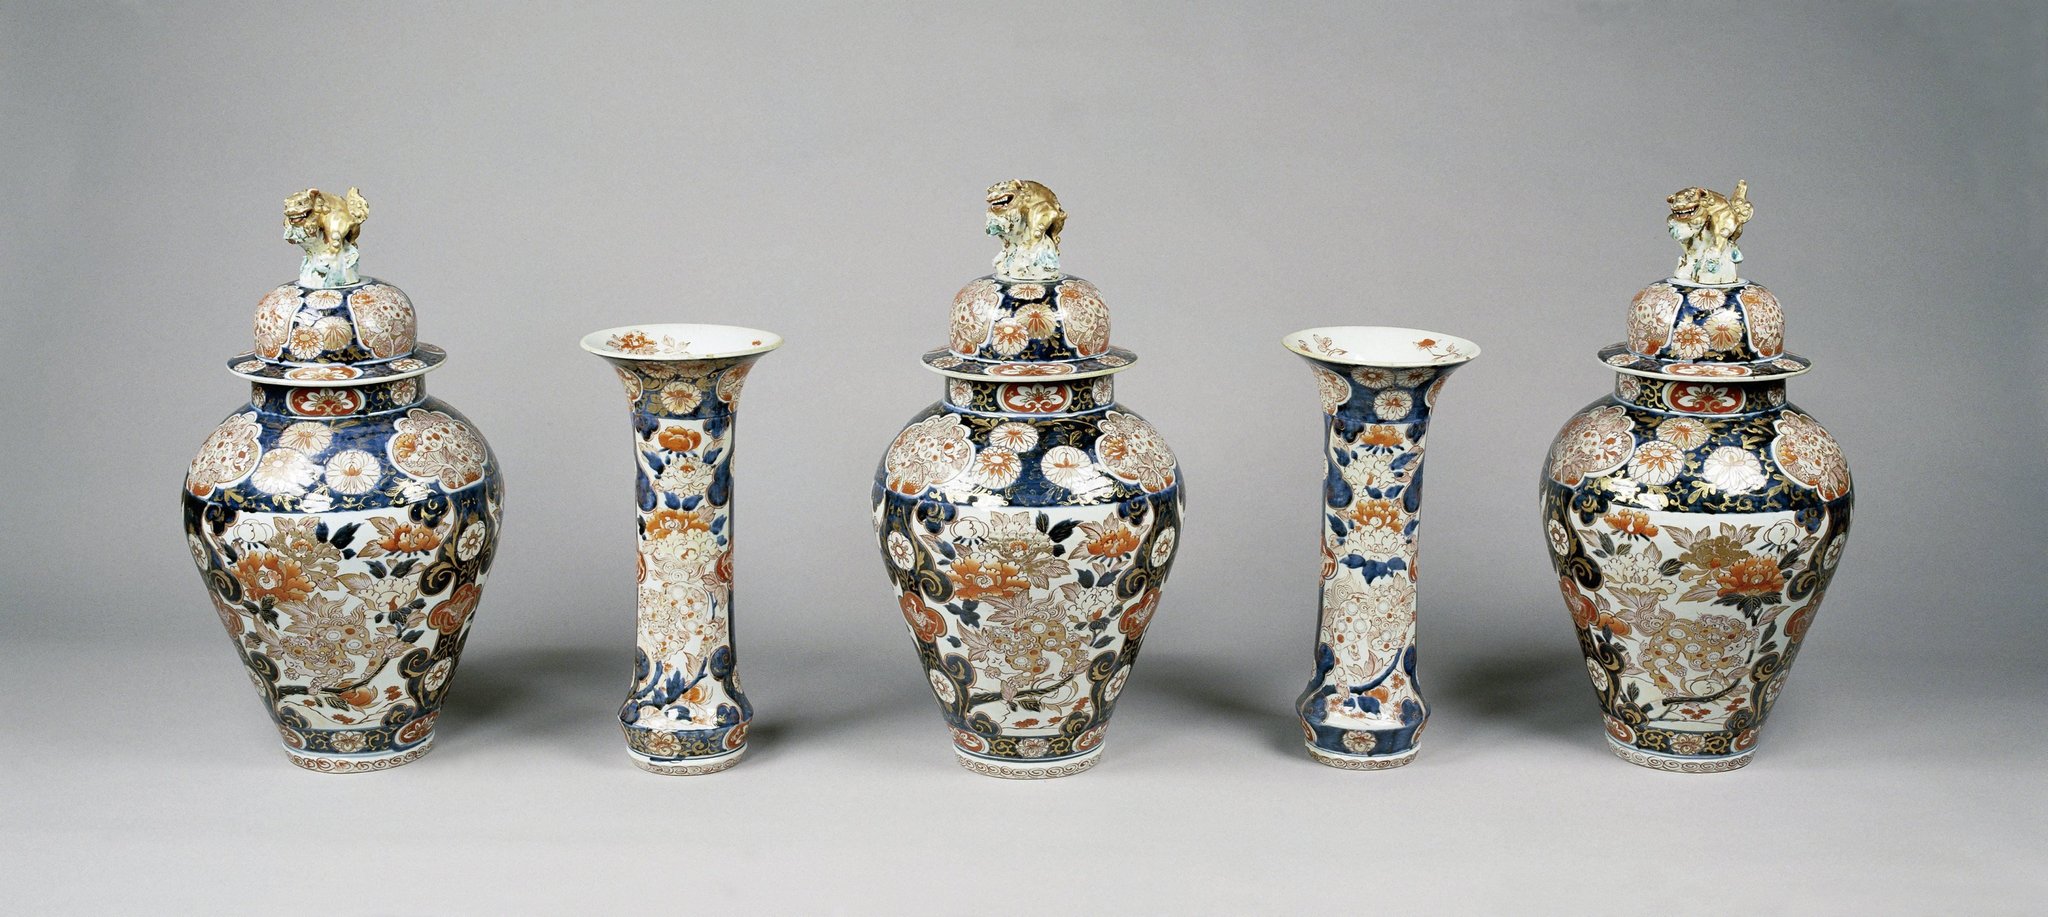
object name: kaststel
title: Covered jar with shishi, hoo-birds, flowering plants and floral scrolls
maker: Anonymous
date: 1775-1824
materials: cobalt, glaze, gold, paint, porcelain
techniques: firing, forming, gilding, turning, vitrification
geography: japan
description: Kaststel, bestaande uit drie potten met deksel en twee bekervormige vazen, in kleuren en goud met druk decor in reserves, Imari.